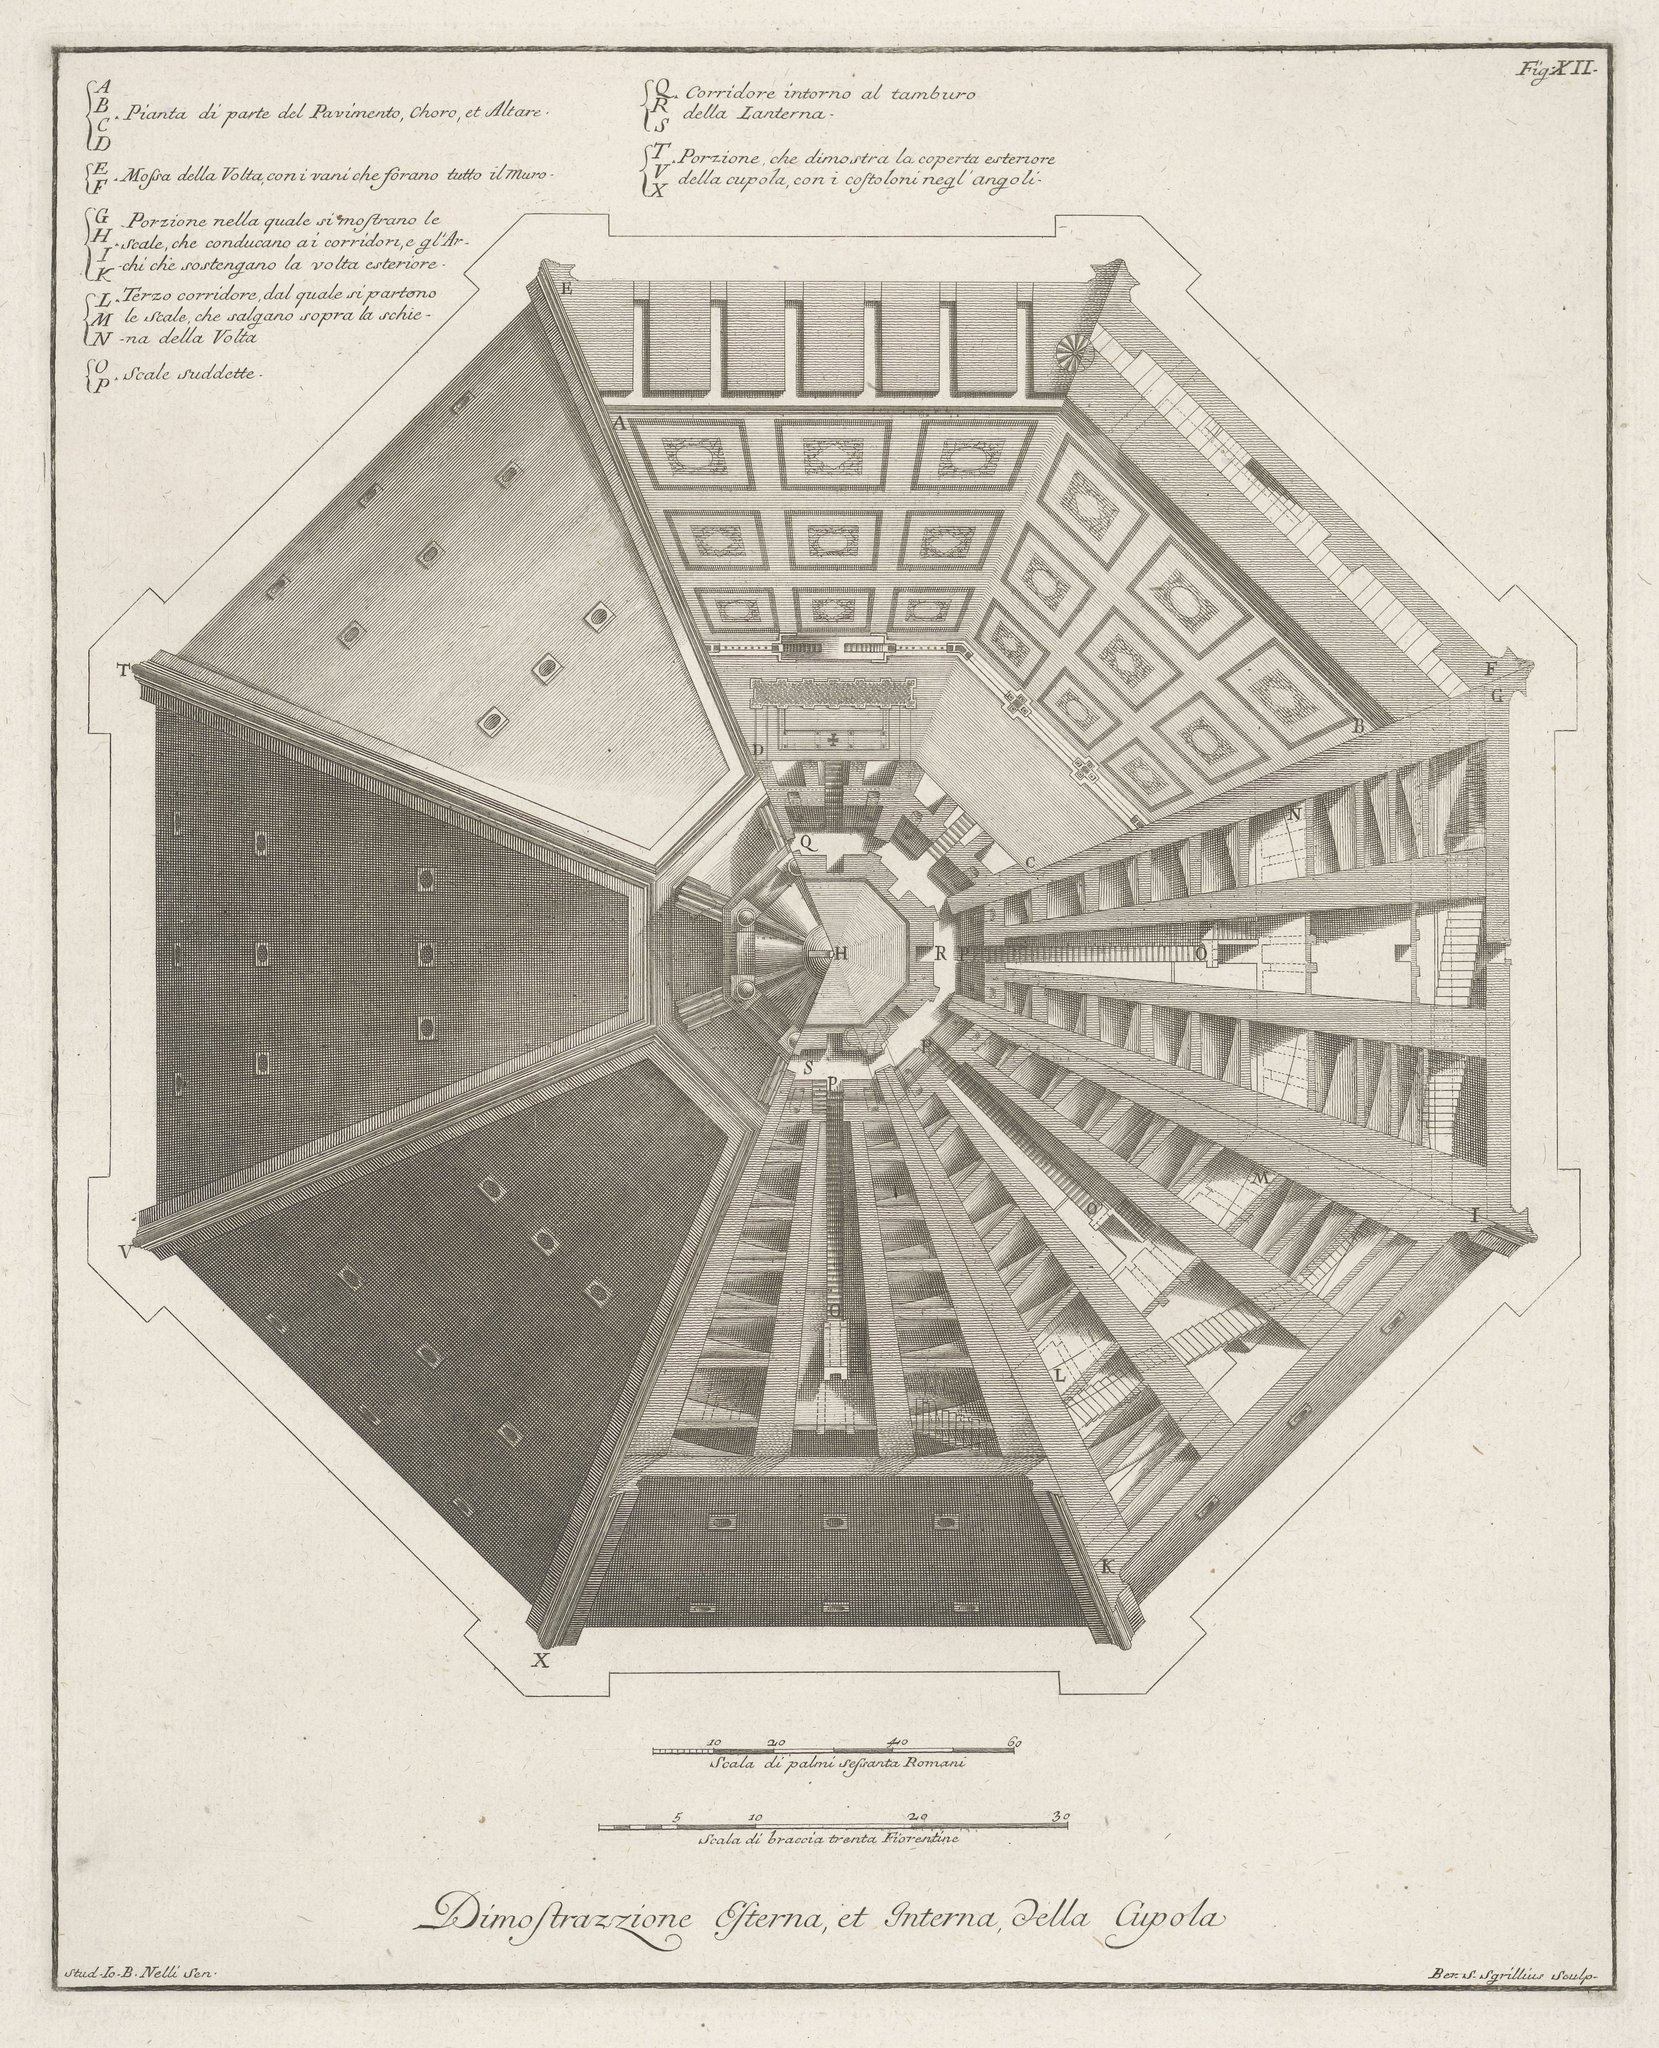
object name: print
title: Dimostrazzione Esterna, et Interna, della Cupola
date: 1733-1755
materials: paper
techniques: etching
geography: italy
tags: roof (of house or building)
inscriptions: collector's mark: Lugt 2228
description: Prent gebruikt voor Sgrilli, Bernardo Sansone. Descrizione e studj dell'insigne fabbrica di Santa Maria del Fiore, metropolitana fiorentina in varie carte intagliati, Florence 1733.